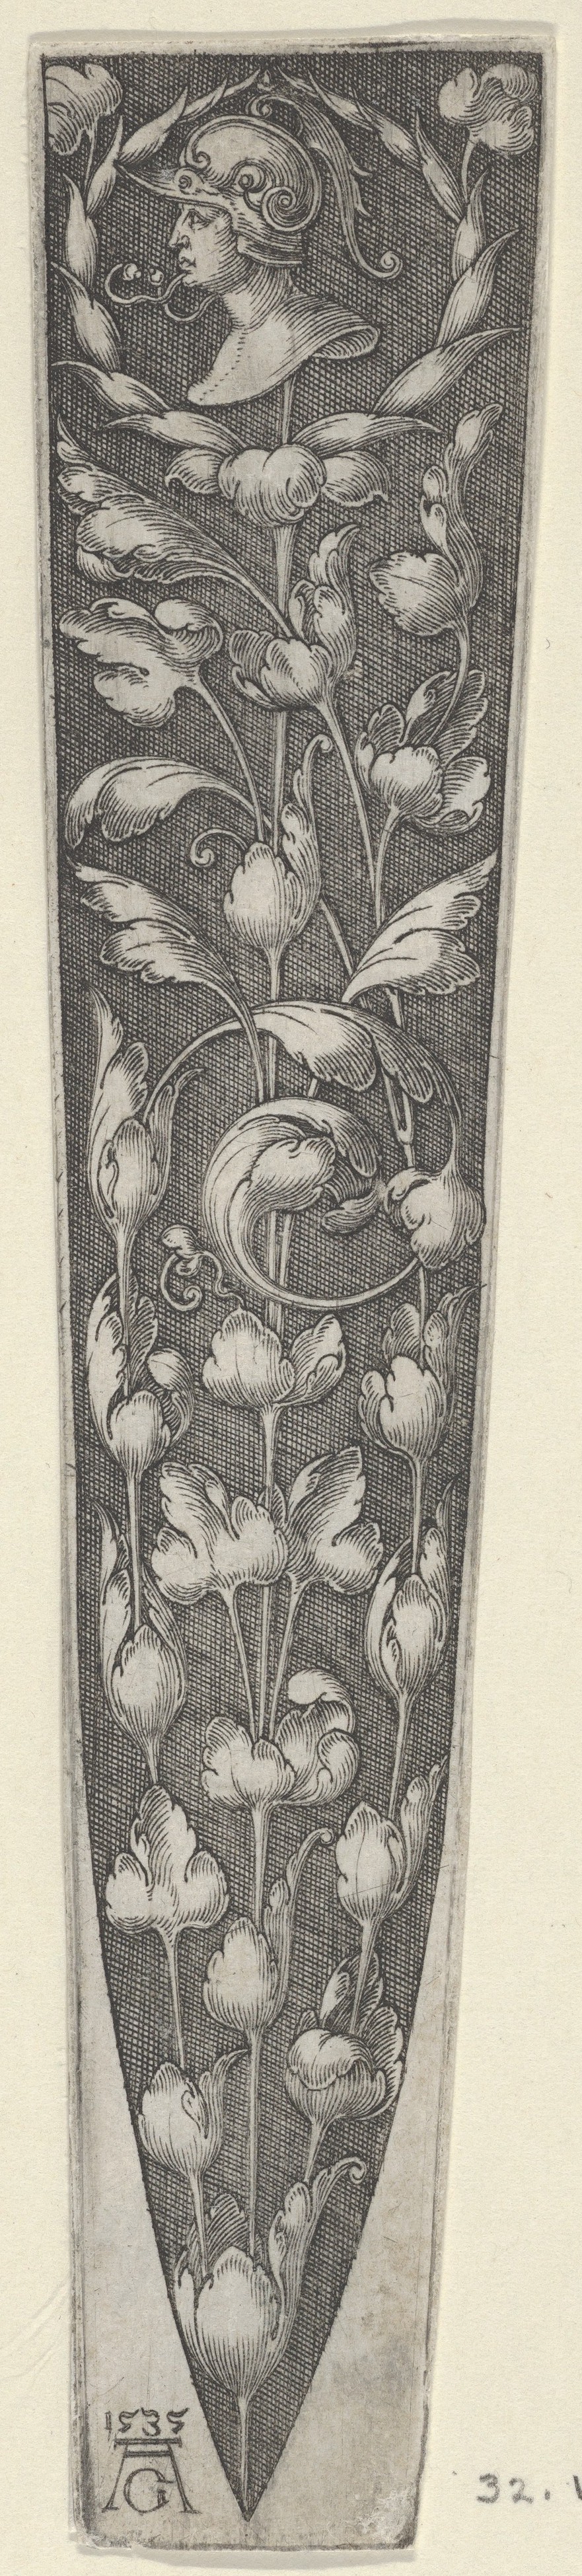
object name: print ornament architecture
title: Dagger Sheath with Profile of a Soldier Supported by Tendrils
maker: heinrich aldegrever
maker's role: artist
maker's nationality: german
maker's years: 1502-1561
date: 1535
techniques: engraving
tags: daggers,ornament